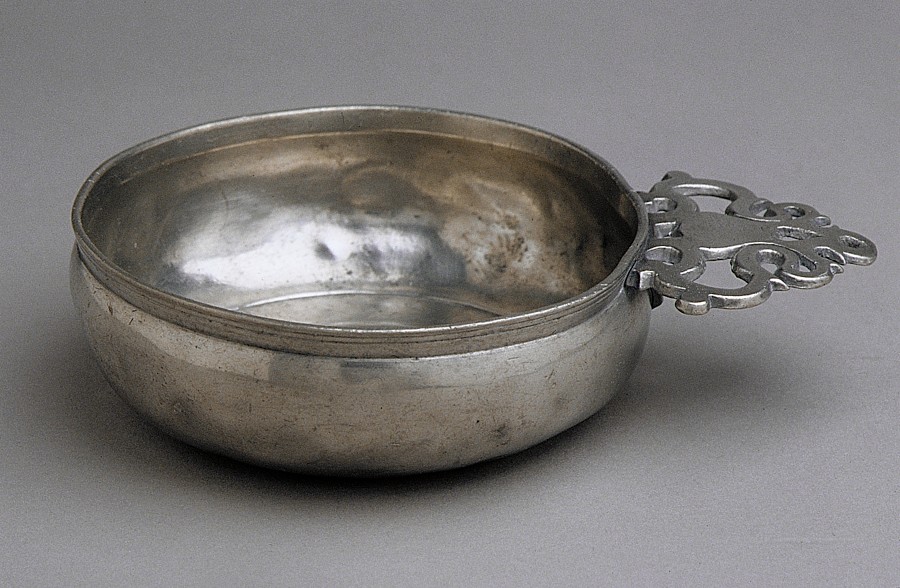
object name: porringer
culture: american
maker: frederick bassett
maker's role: maker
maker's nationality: american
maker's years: 1740-1800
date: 1761-1799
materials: pewter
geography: united states